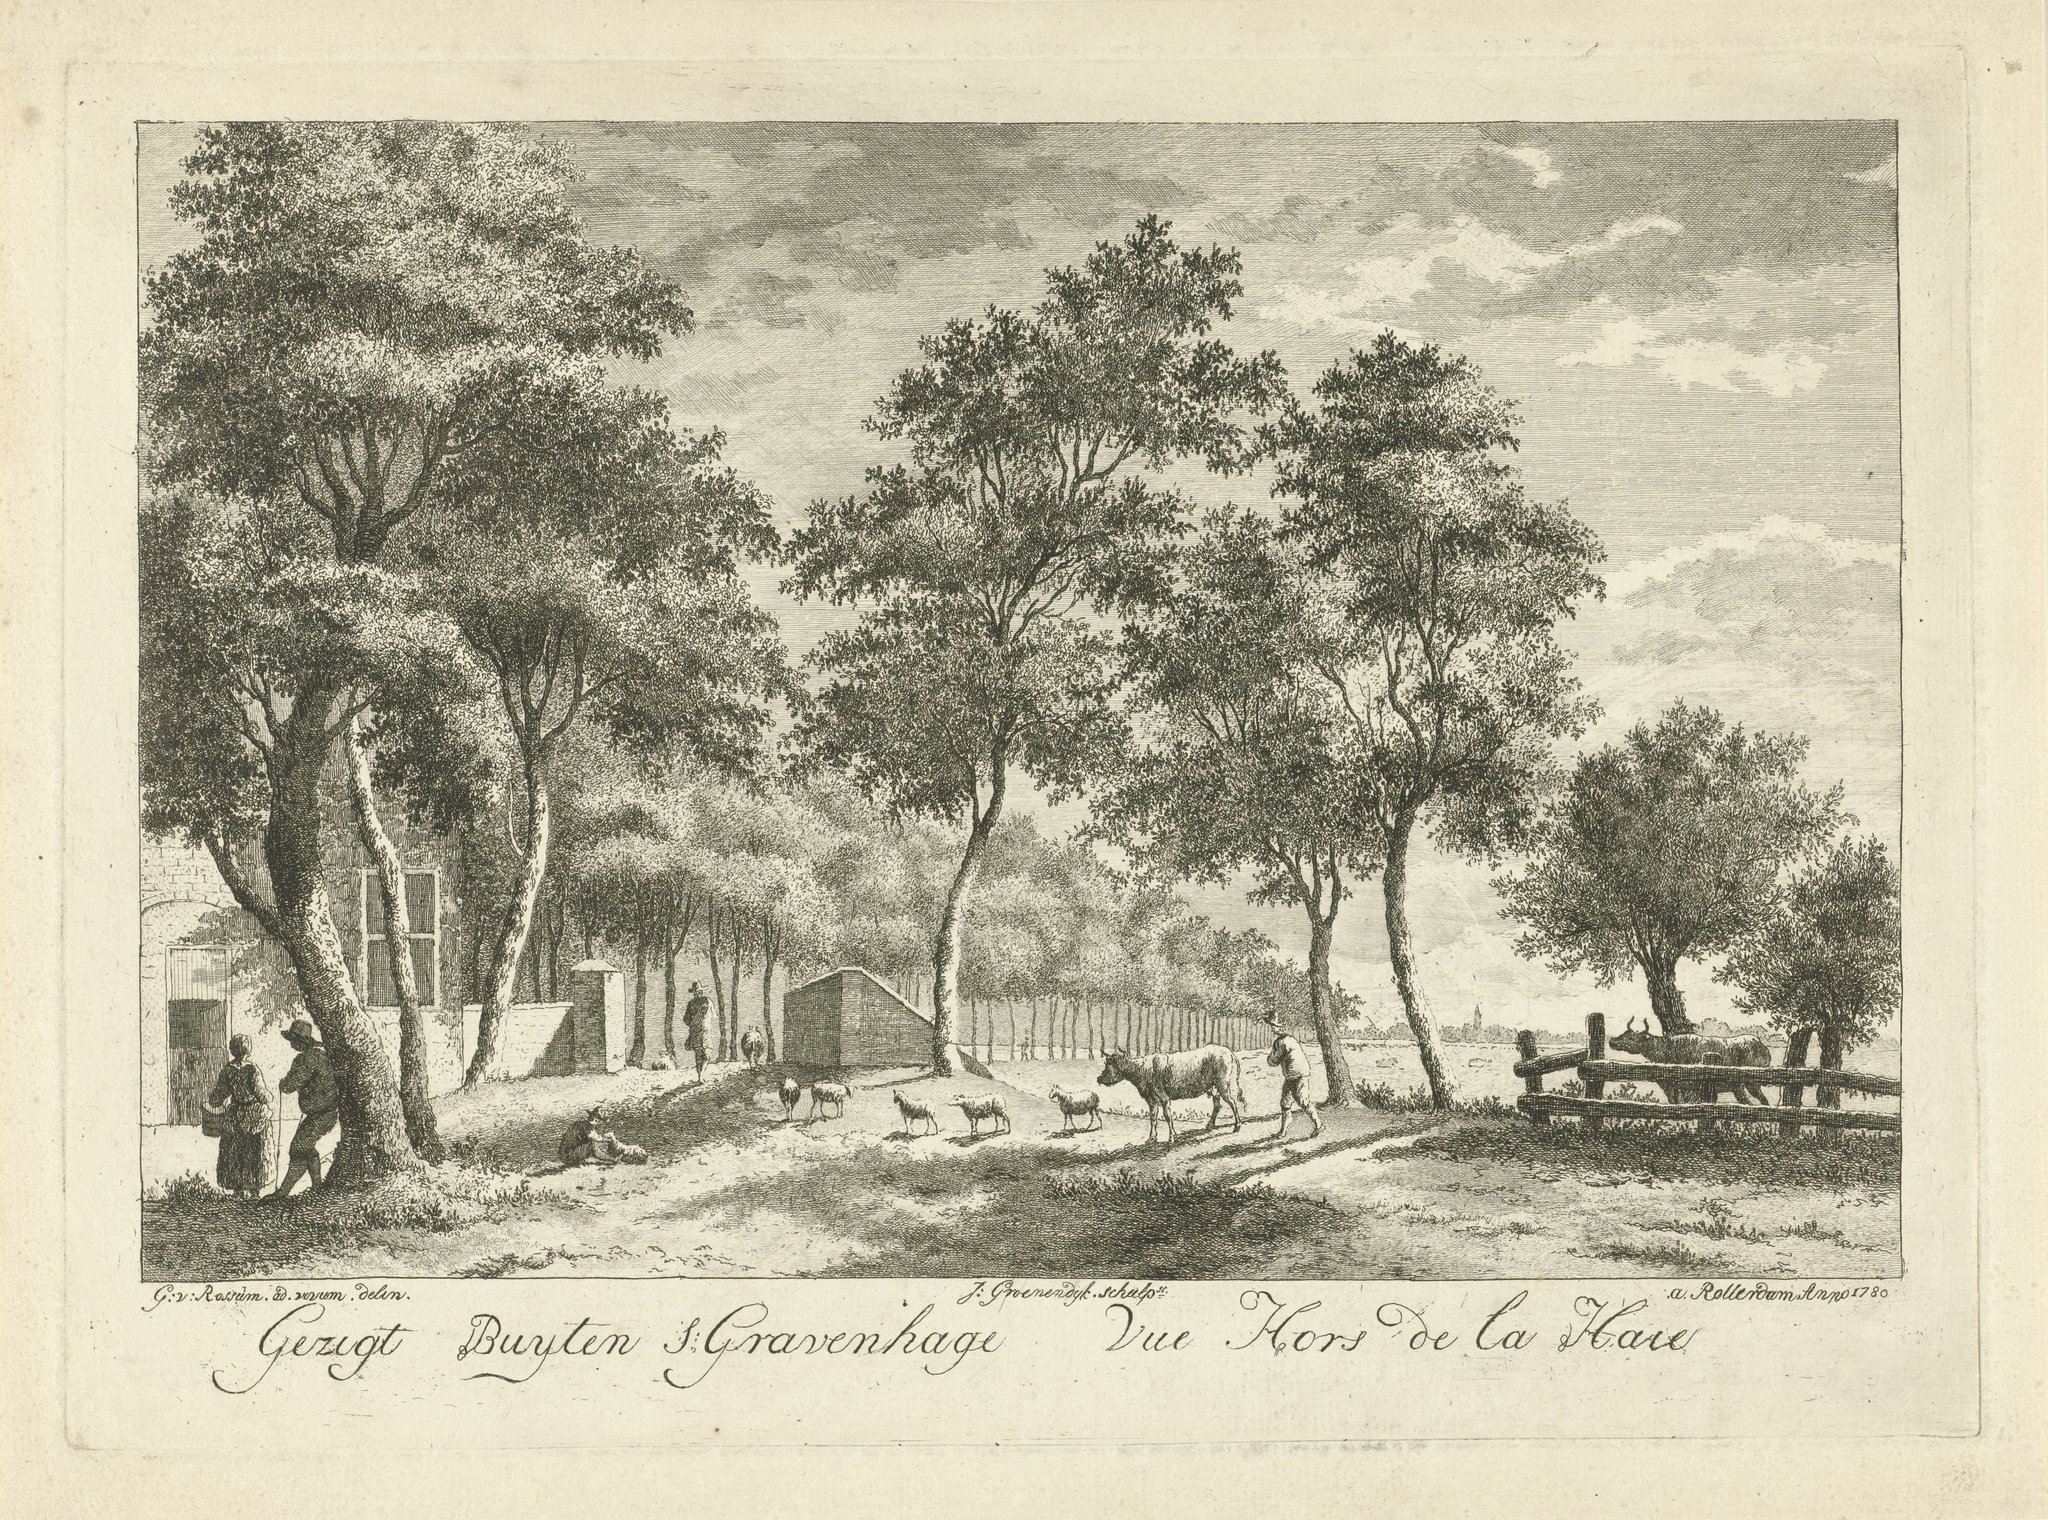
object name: print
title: Gezigt buyten s'Gravenhage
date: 1781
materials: paper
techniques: etching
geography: rotterdam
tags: herding, herdsman, herdswoman, shepherd, shepherdess, cowherd, etc., public road in village (+ city(-scape) with figures, staffage), the hague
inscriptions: collector's mark: Lugt 2228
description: Een landweg met schapen, een koe en een herder. Op de achtergrond Den Haag.